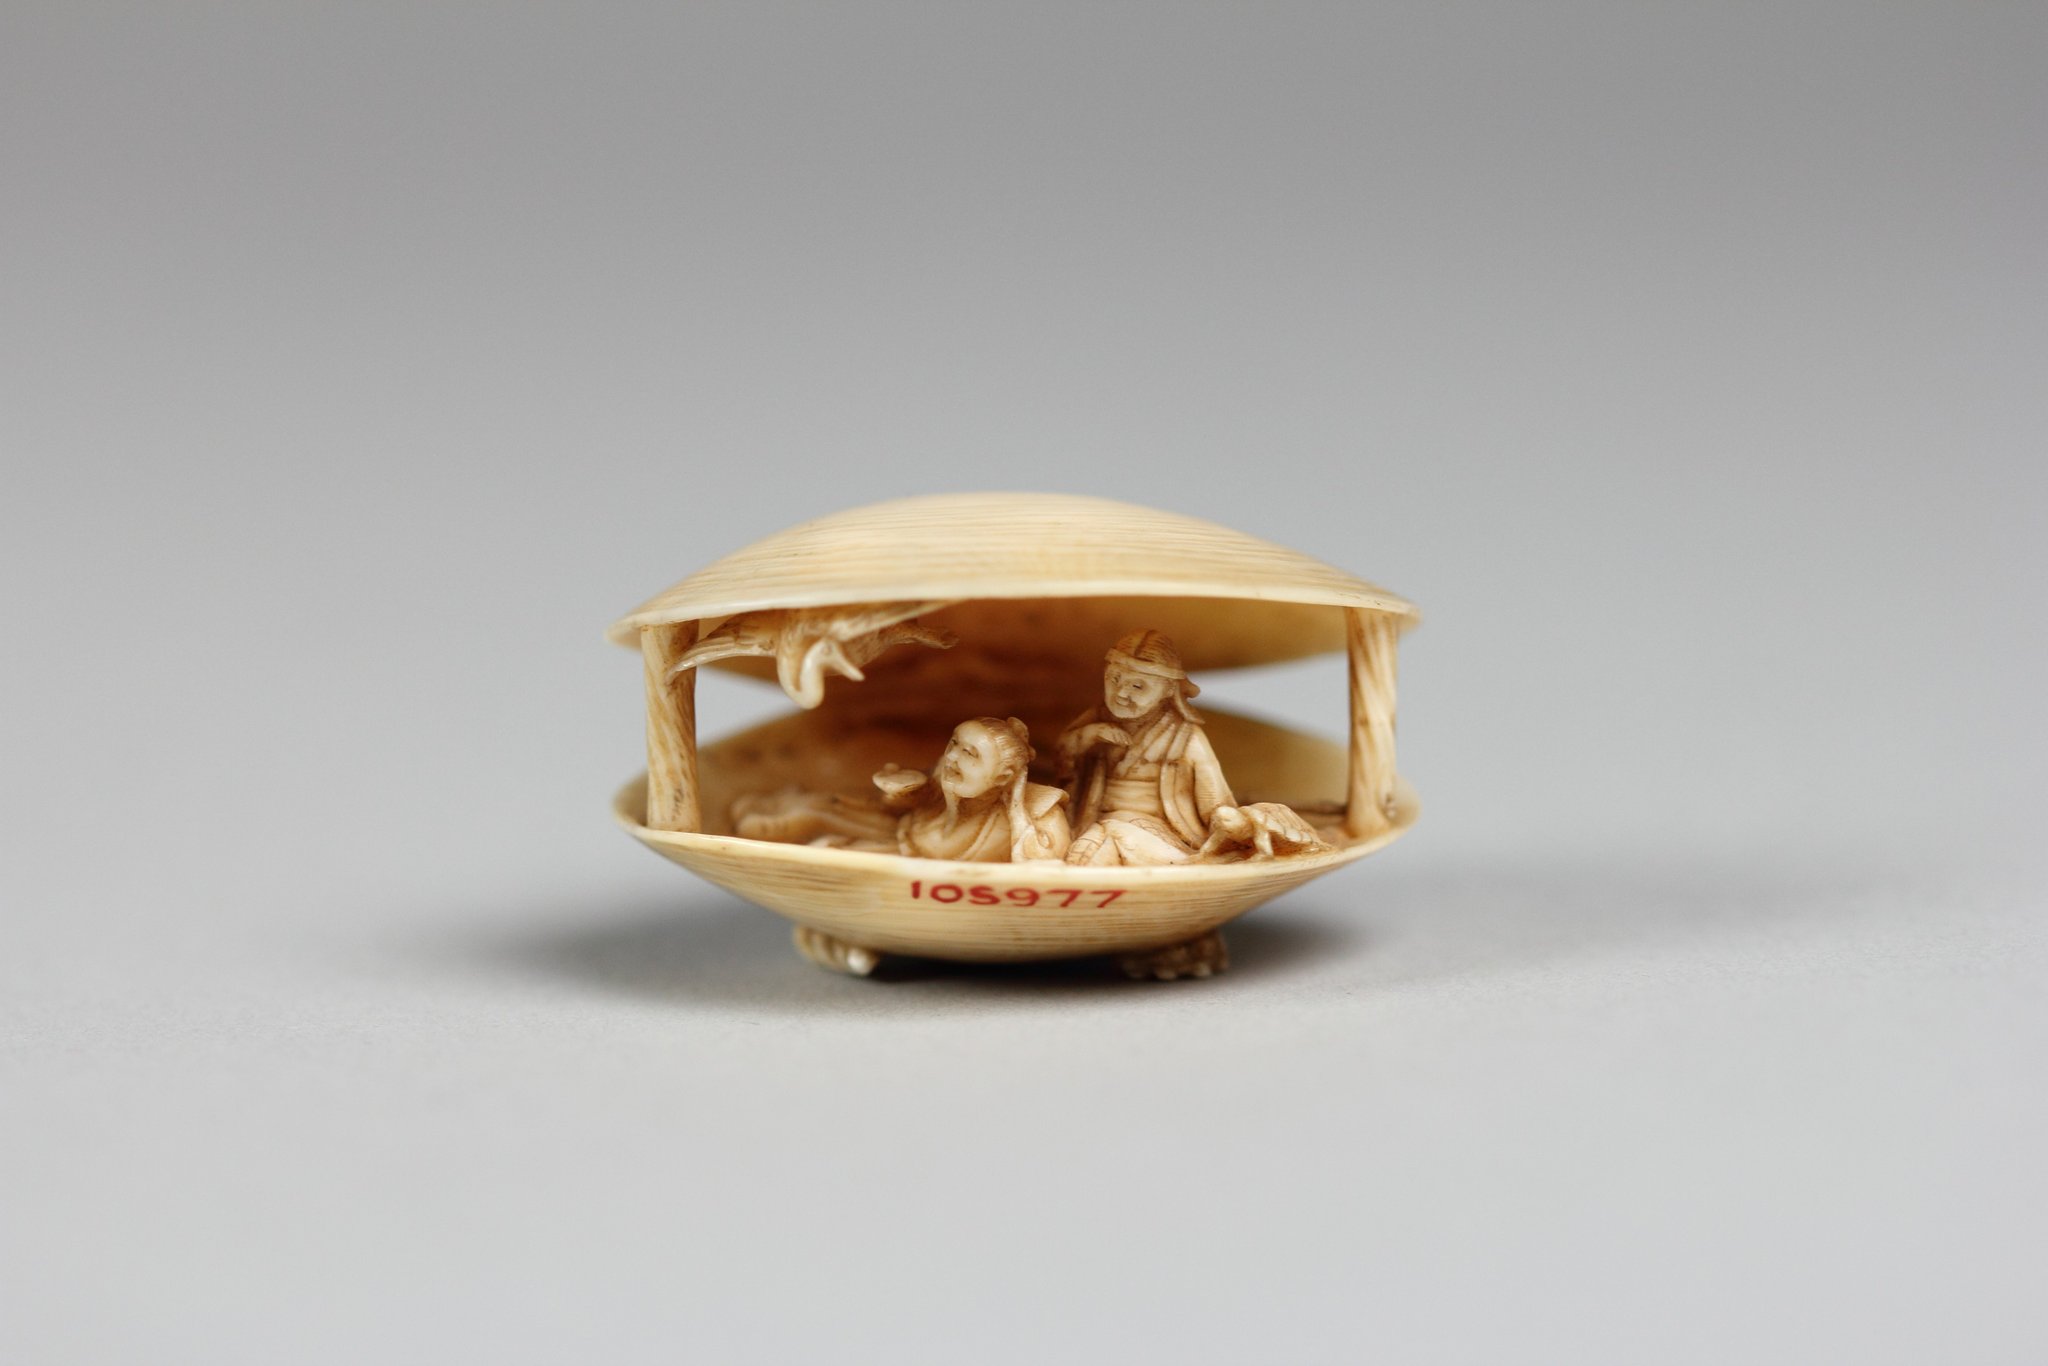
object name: netsuke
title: Netsuke of Clamshell Containing Figures and Bird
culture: japanese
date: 1801-1900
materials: ivory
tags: human figures,birds,shells